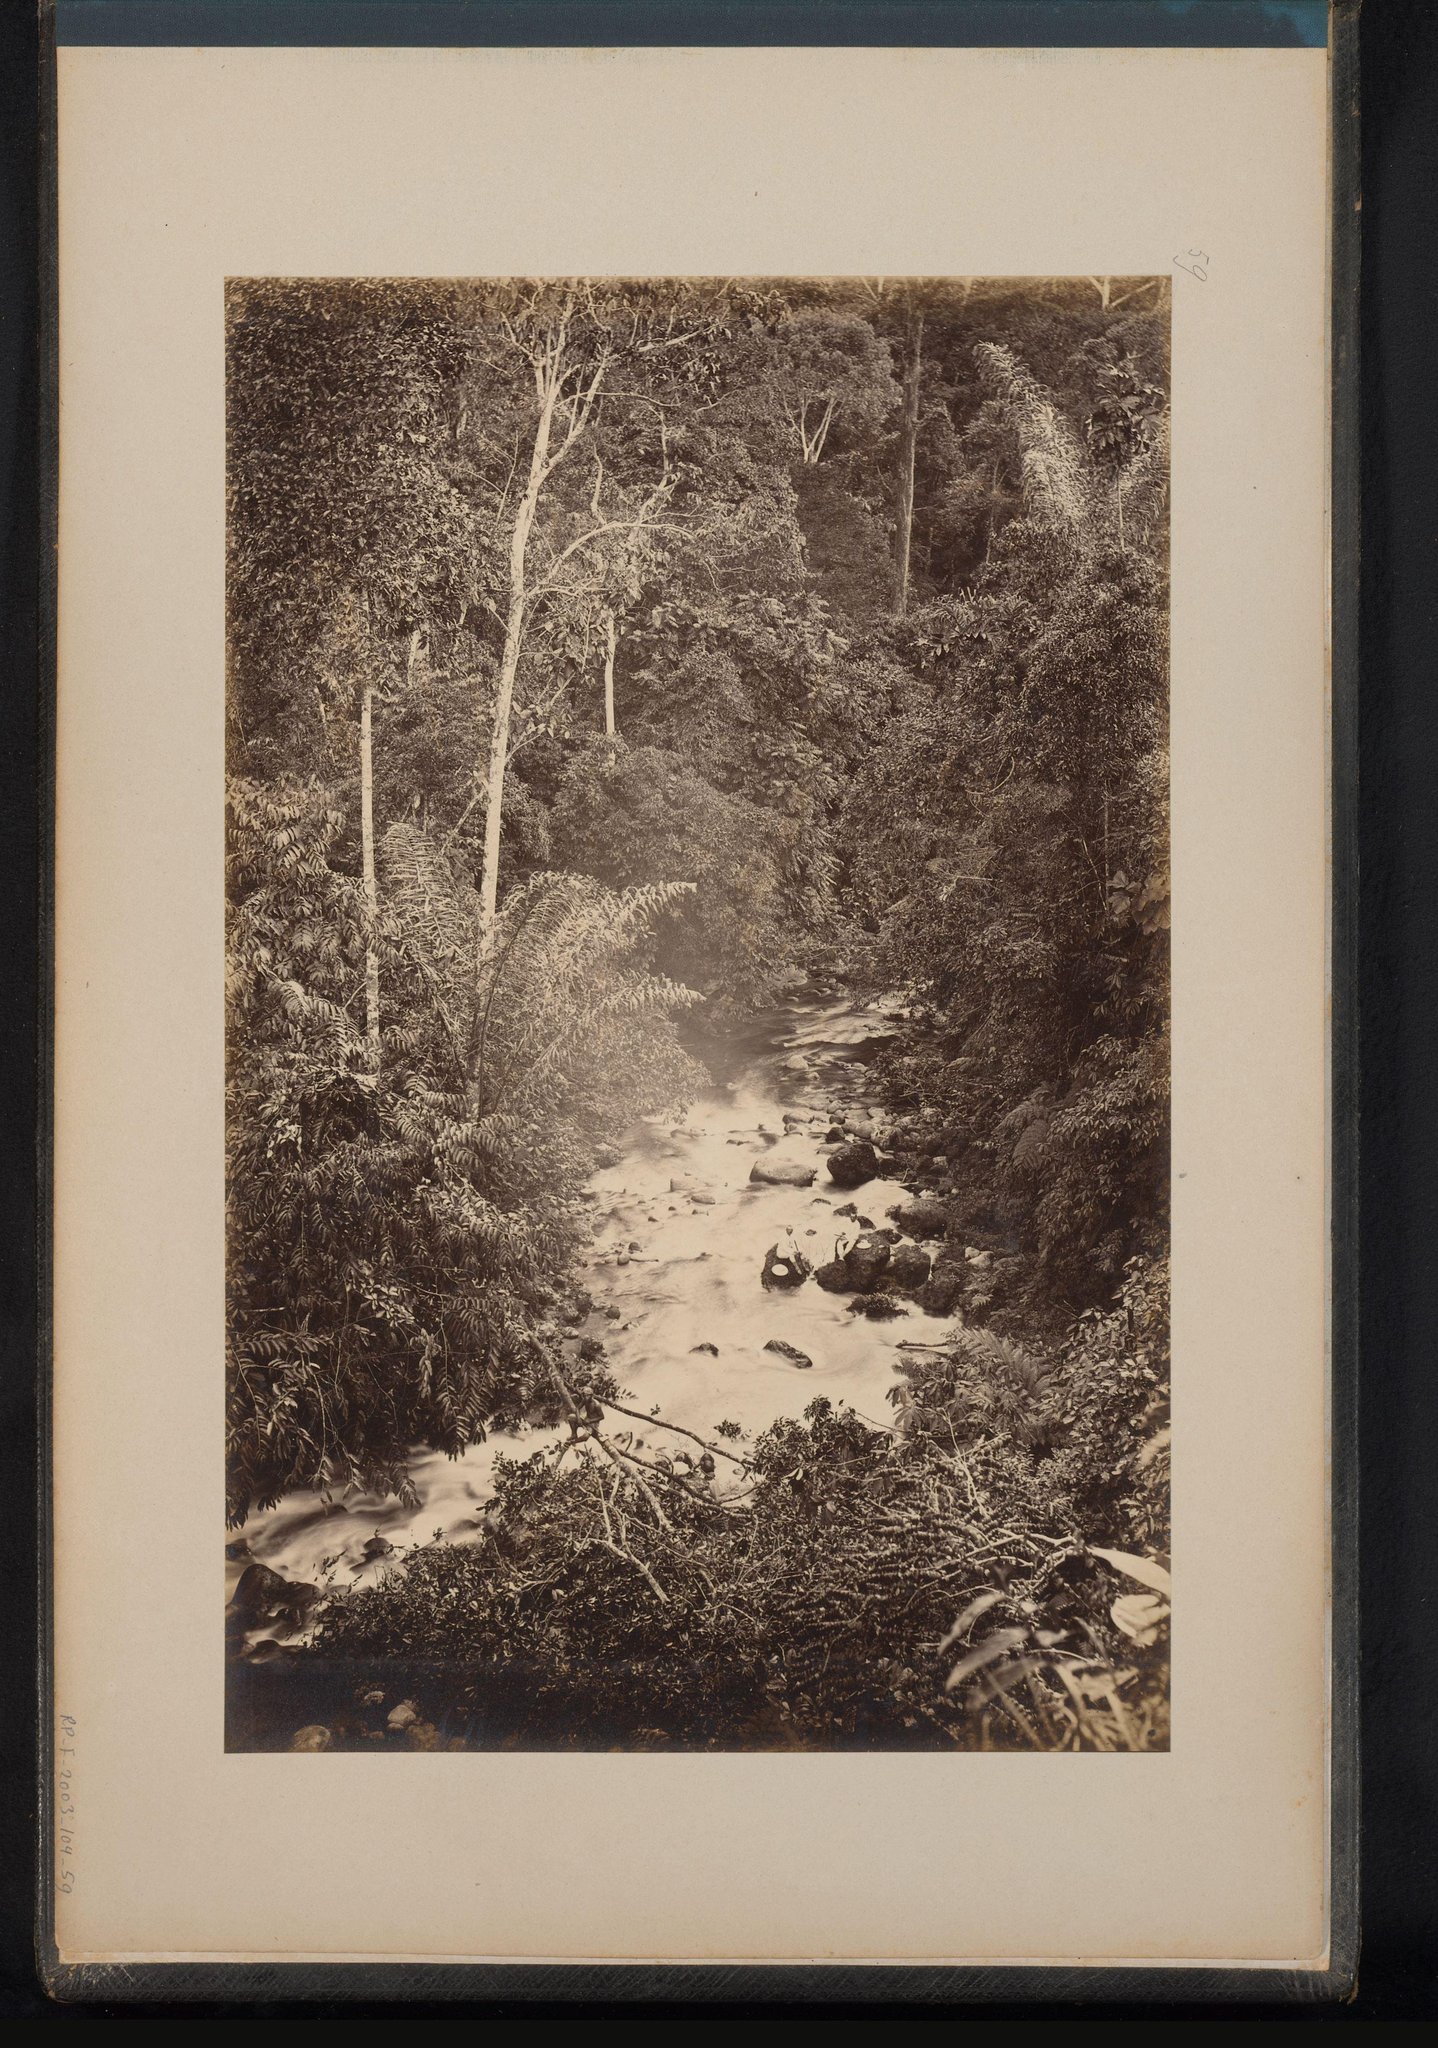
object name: photograph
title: Waterval in Pamoe-Oekoer, Sumatra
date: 1890-1900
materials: cardboard, photographic support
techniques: albumen print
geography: sumatra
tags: waterfall, sumatra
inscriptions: number: ‘59’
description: In de lijst van afbeeldingen wordt deze foto beschreven met de woorden "Gebirgsfluss in Pamoe-Oekoer".